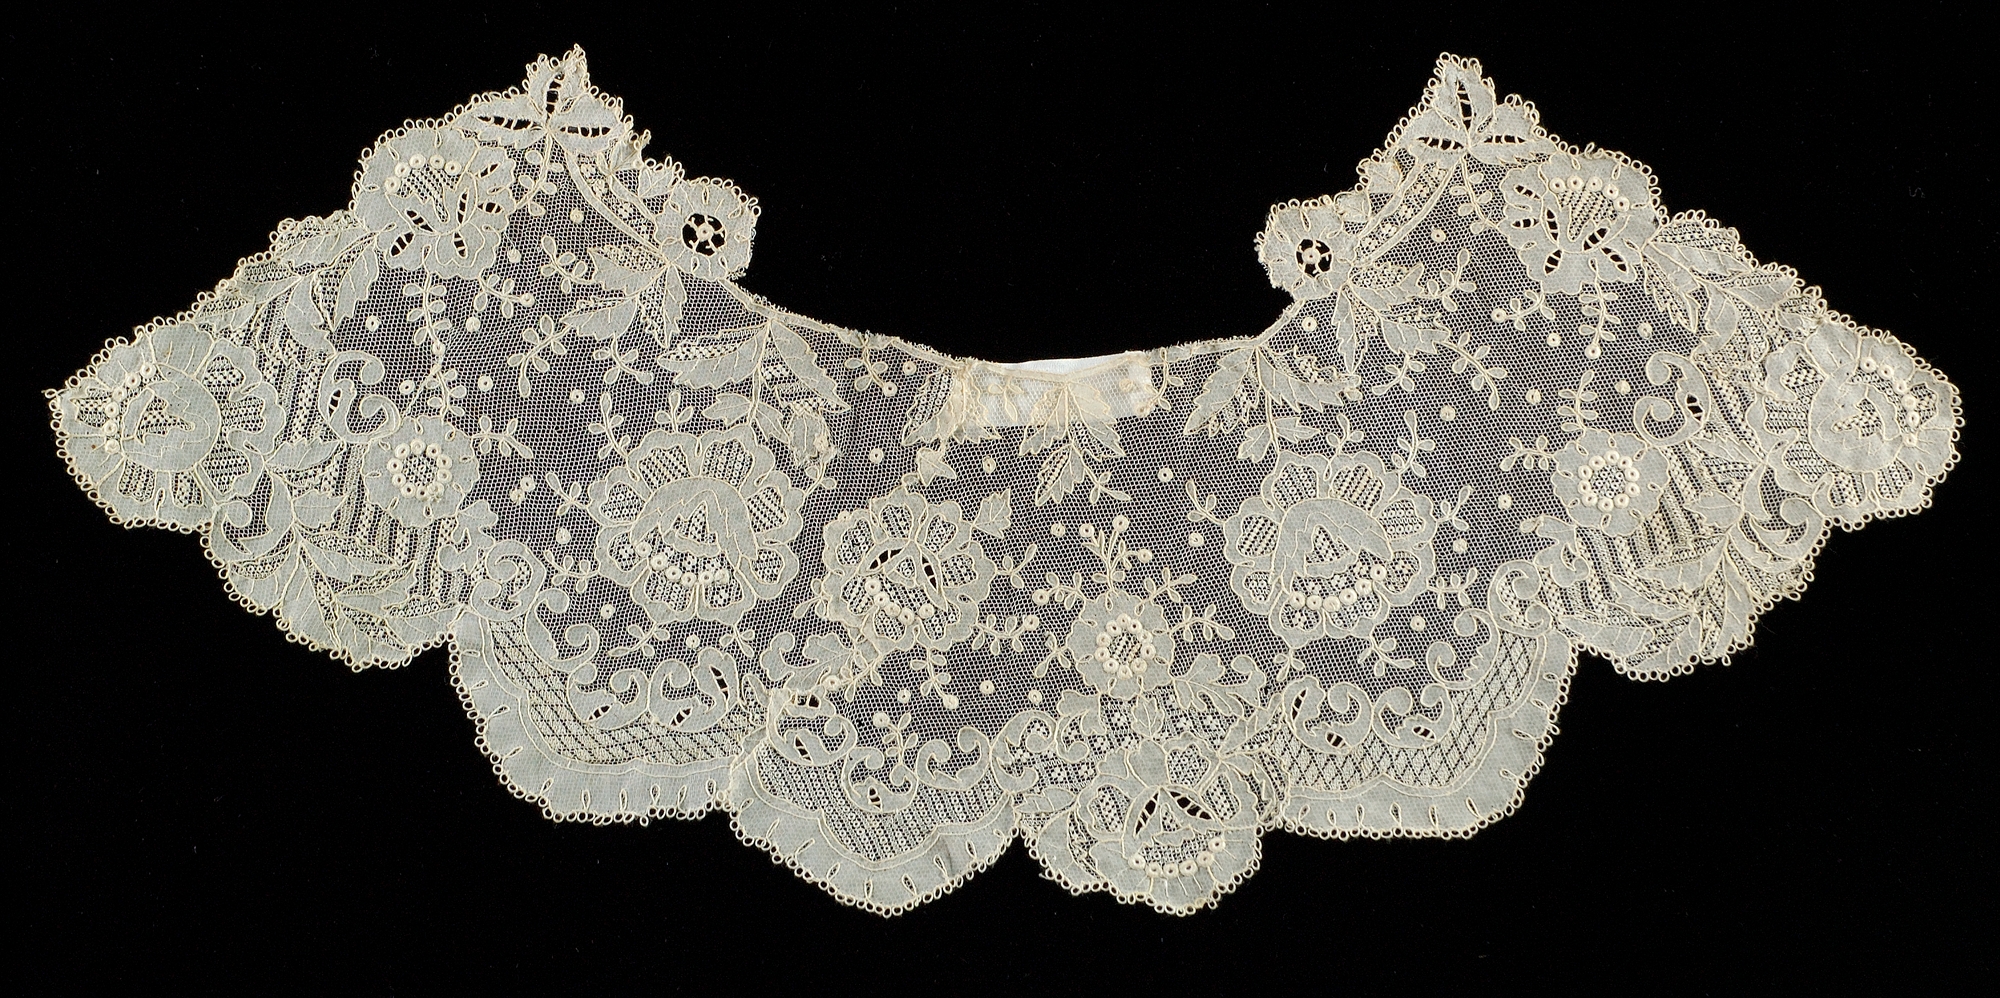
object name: collar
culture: irish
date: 1890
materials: cotton, linen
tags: flowers